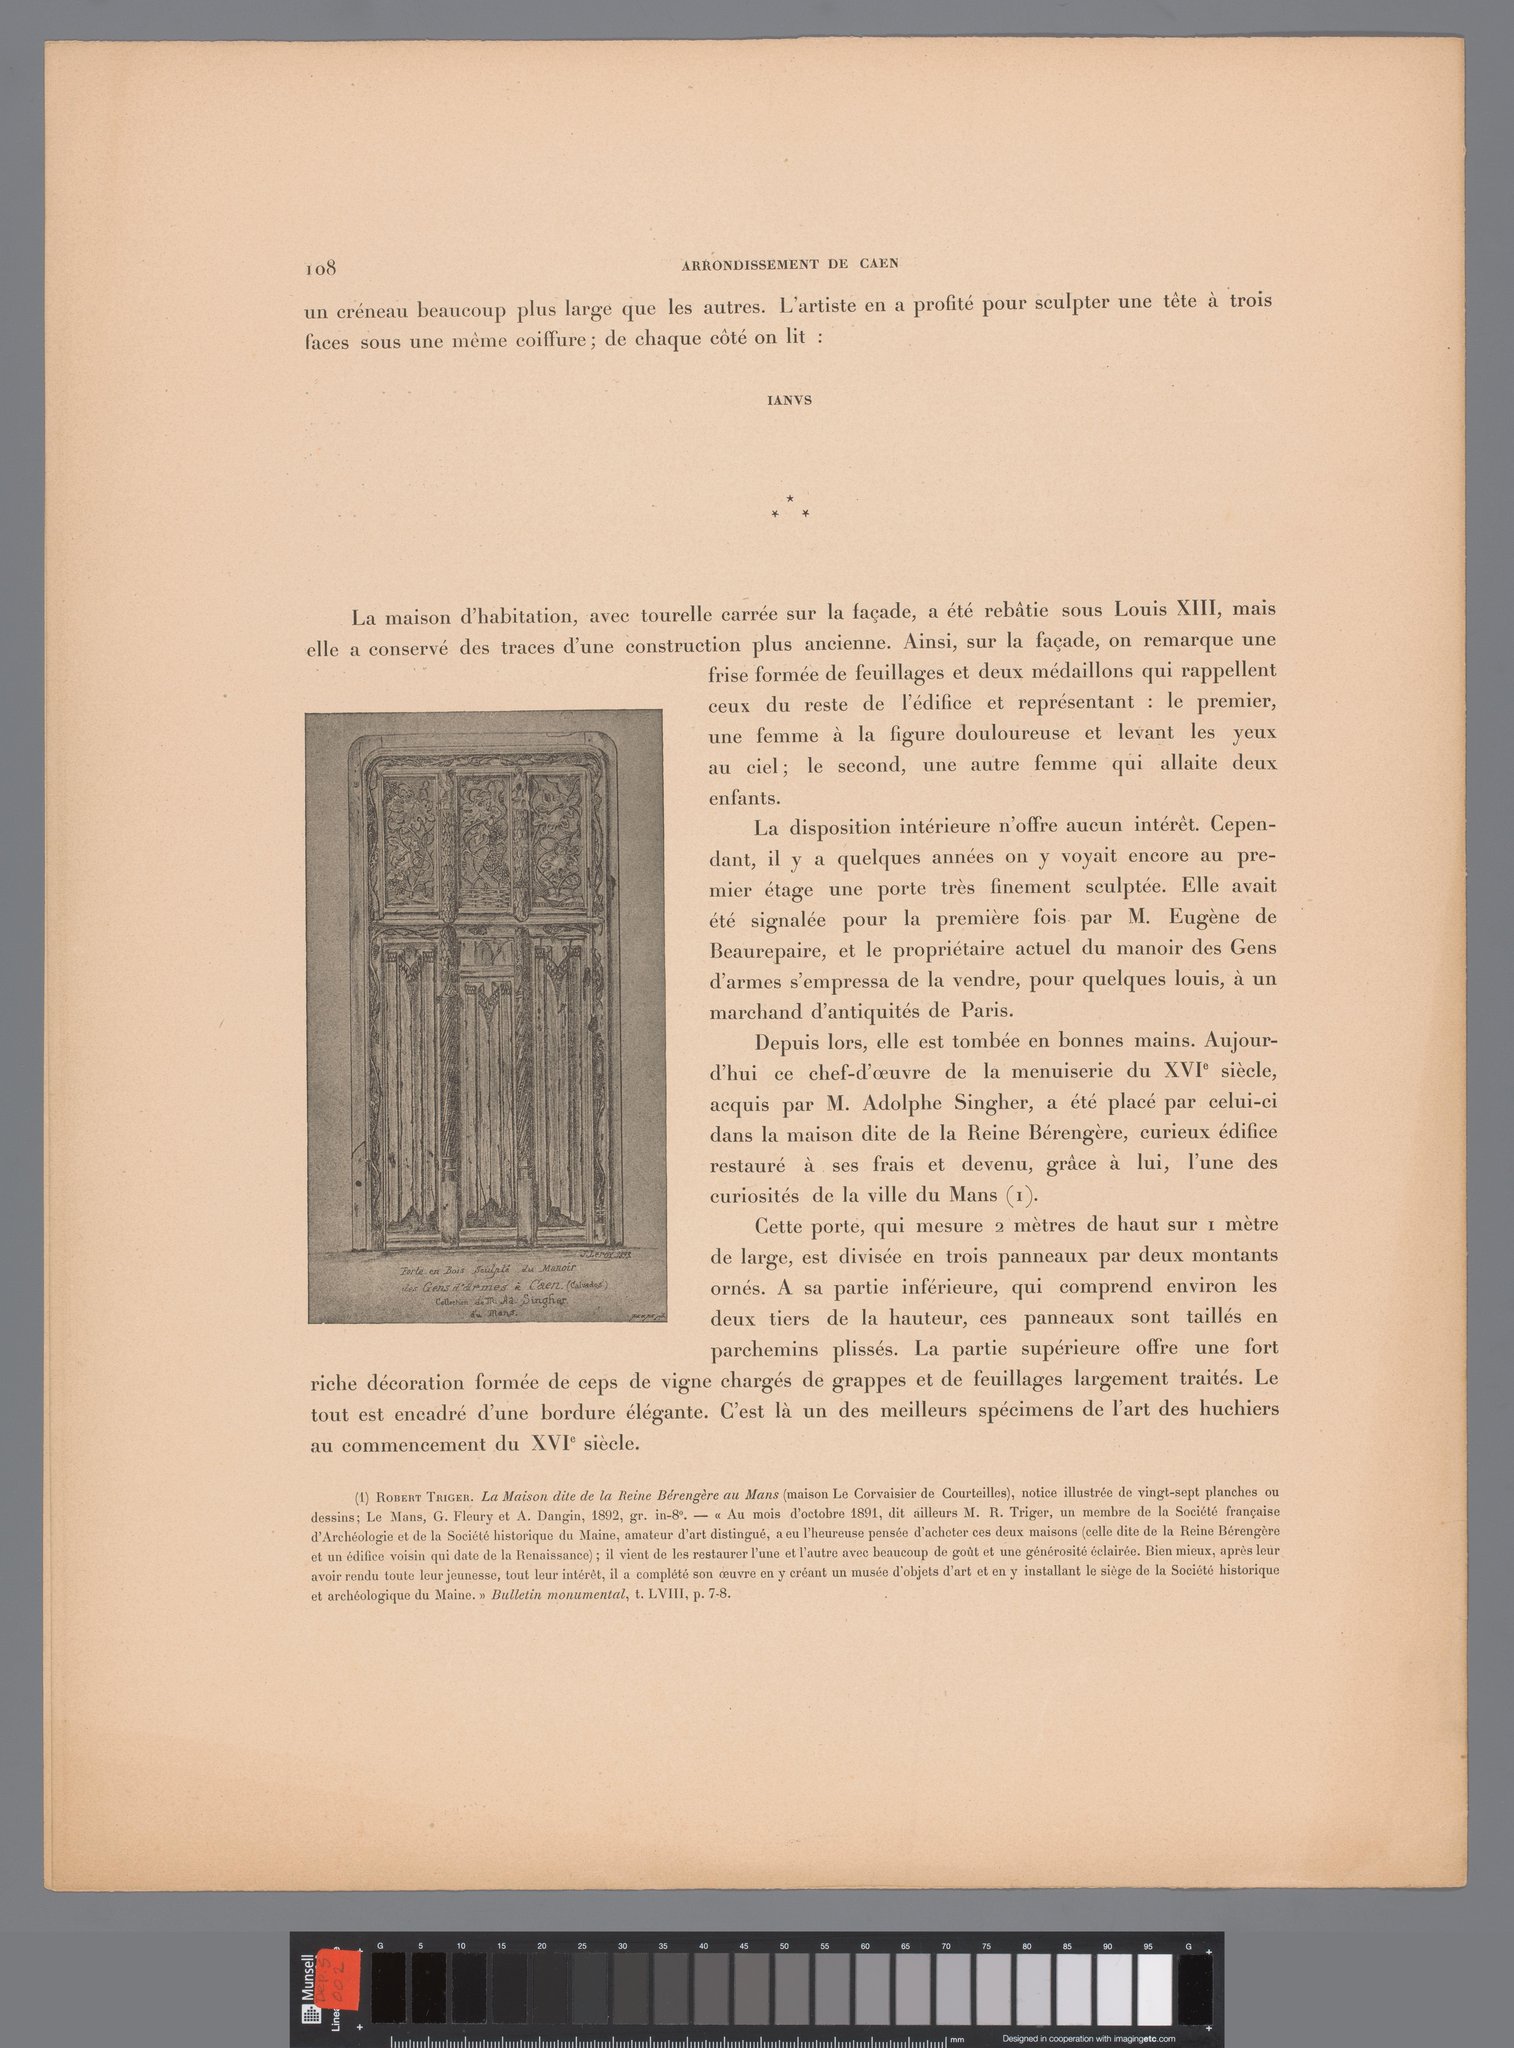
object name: photomechanical print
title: Église de Briquebec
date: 1890-1895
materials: paper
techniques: photoaquatint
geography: bricquebec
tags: church (exterior)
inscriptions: inscription: ‘Manche’, number: ‘Pl. No. 41’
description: Deze prent maakt deel uit van een omslag met 12 prenten en 46 tekstbladen.